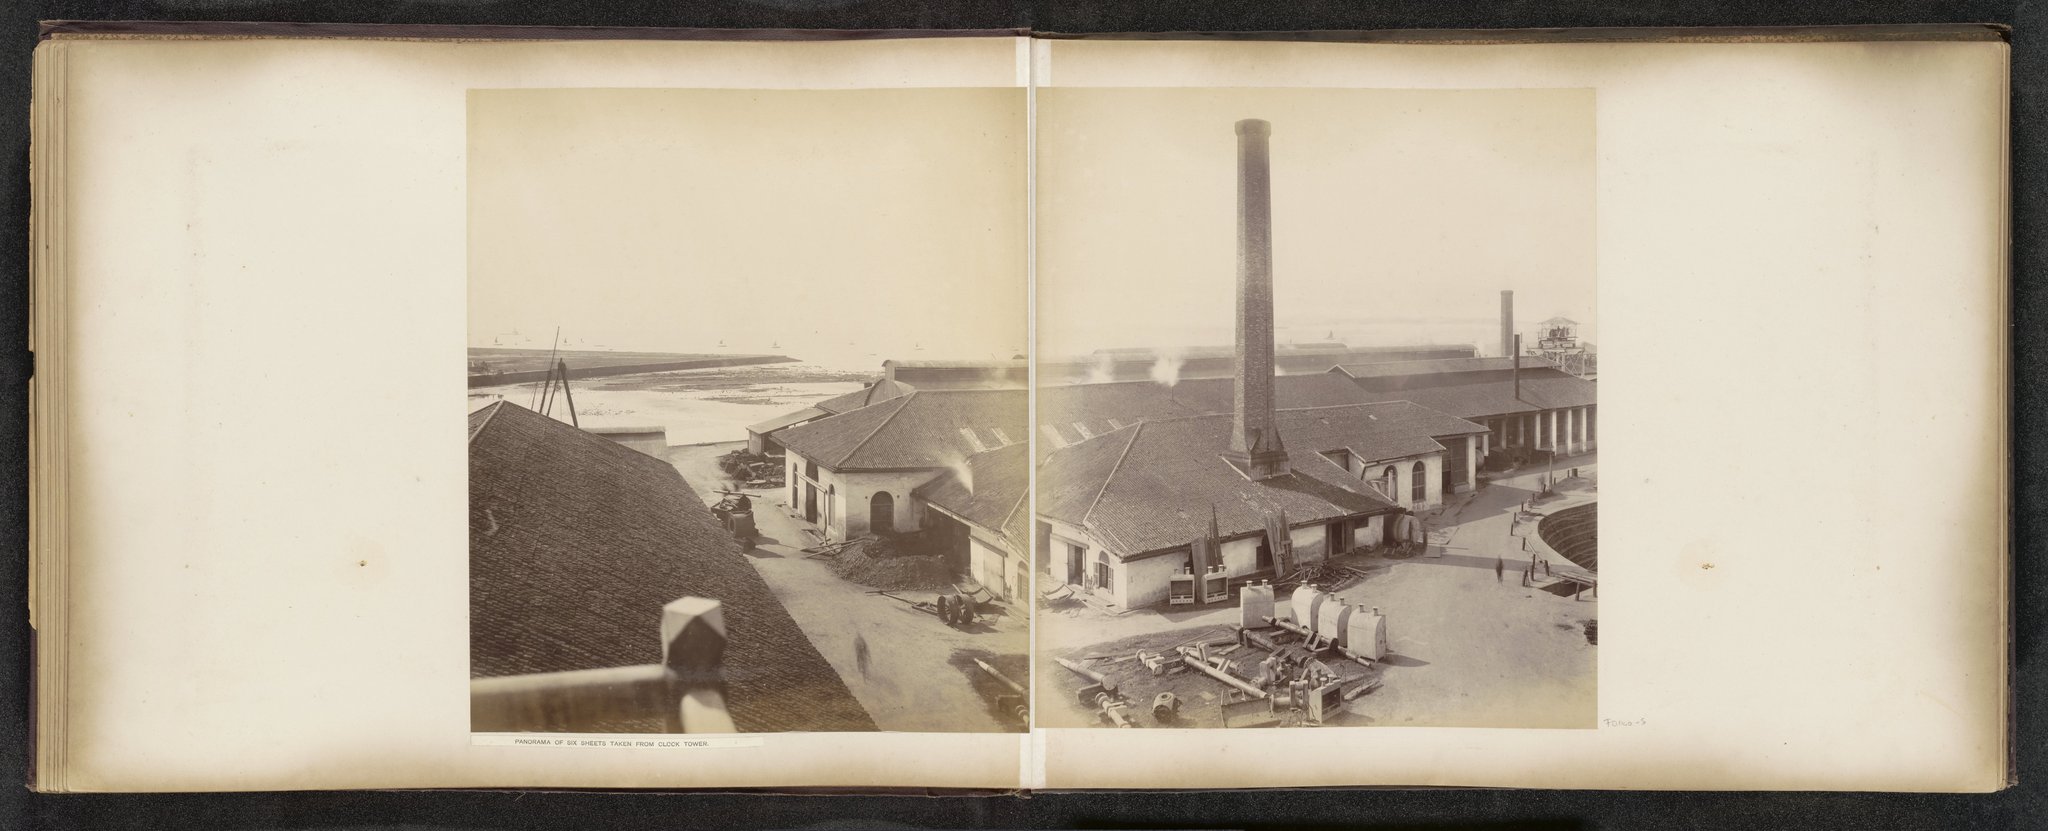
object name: panoramic photograph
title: Gezicht op de gebouwen en dokken van de Tanjong Pagar Dock Co. Ltd. in Singapore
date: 1890-1905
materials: photographic support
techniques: albumen print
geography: singapore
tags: pier, quay, wharf, shipyard, shipdock, shipbuilding industry, singapore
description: Panorama bestaande uit zes afdrukken. Onderdeel van Fotoalbum van de Tanjong Pagar Dock Co. Ltd. in Singapore.